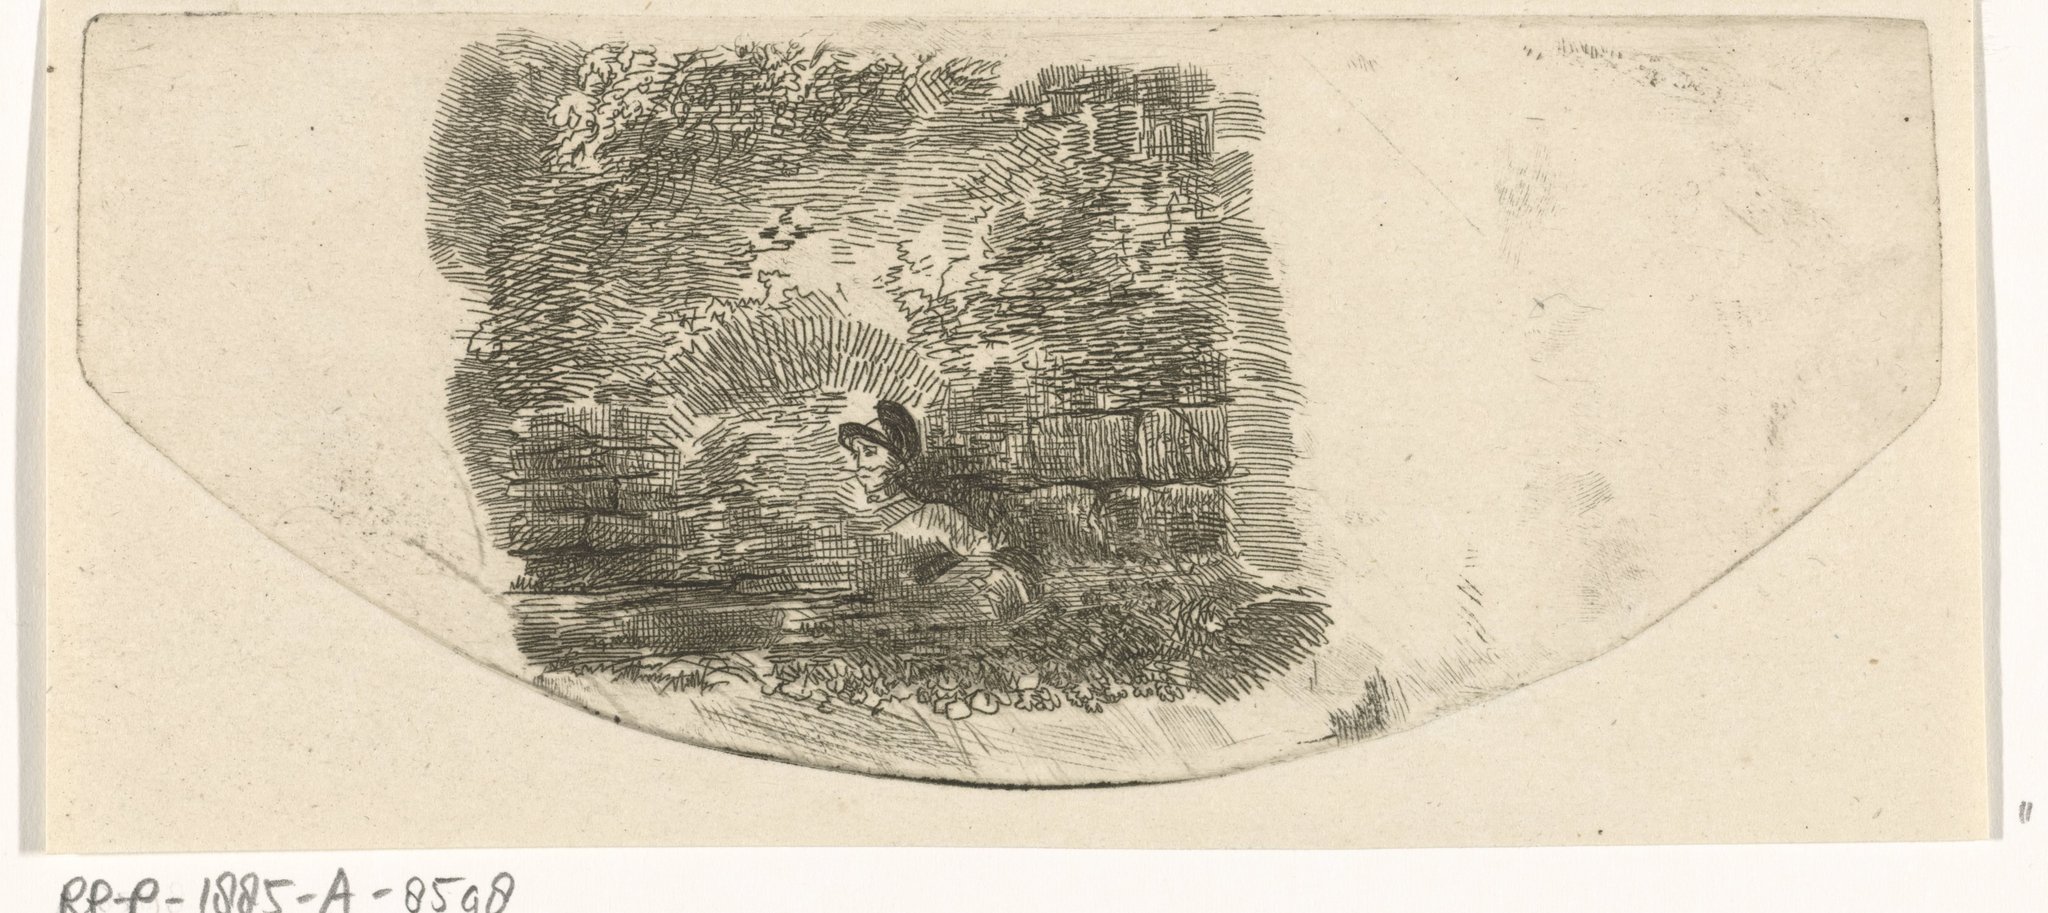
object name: print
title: Muur en het gezicht van een man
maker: johannes mock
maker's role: draughtsman, painter, print maker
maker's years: 1800-1884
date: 1810-1884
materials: paper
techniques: etching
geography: netherlands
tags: head (human), fence, wall, paling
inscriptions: collector's mark: Lugt 2228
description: Studieblad met een muur en daarvoor het gezicht van een man.